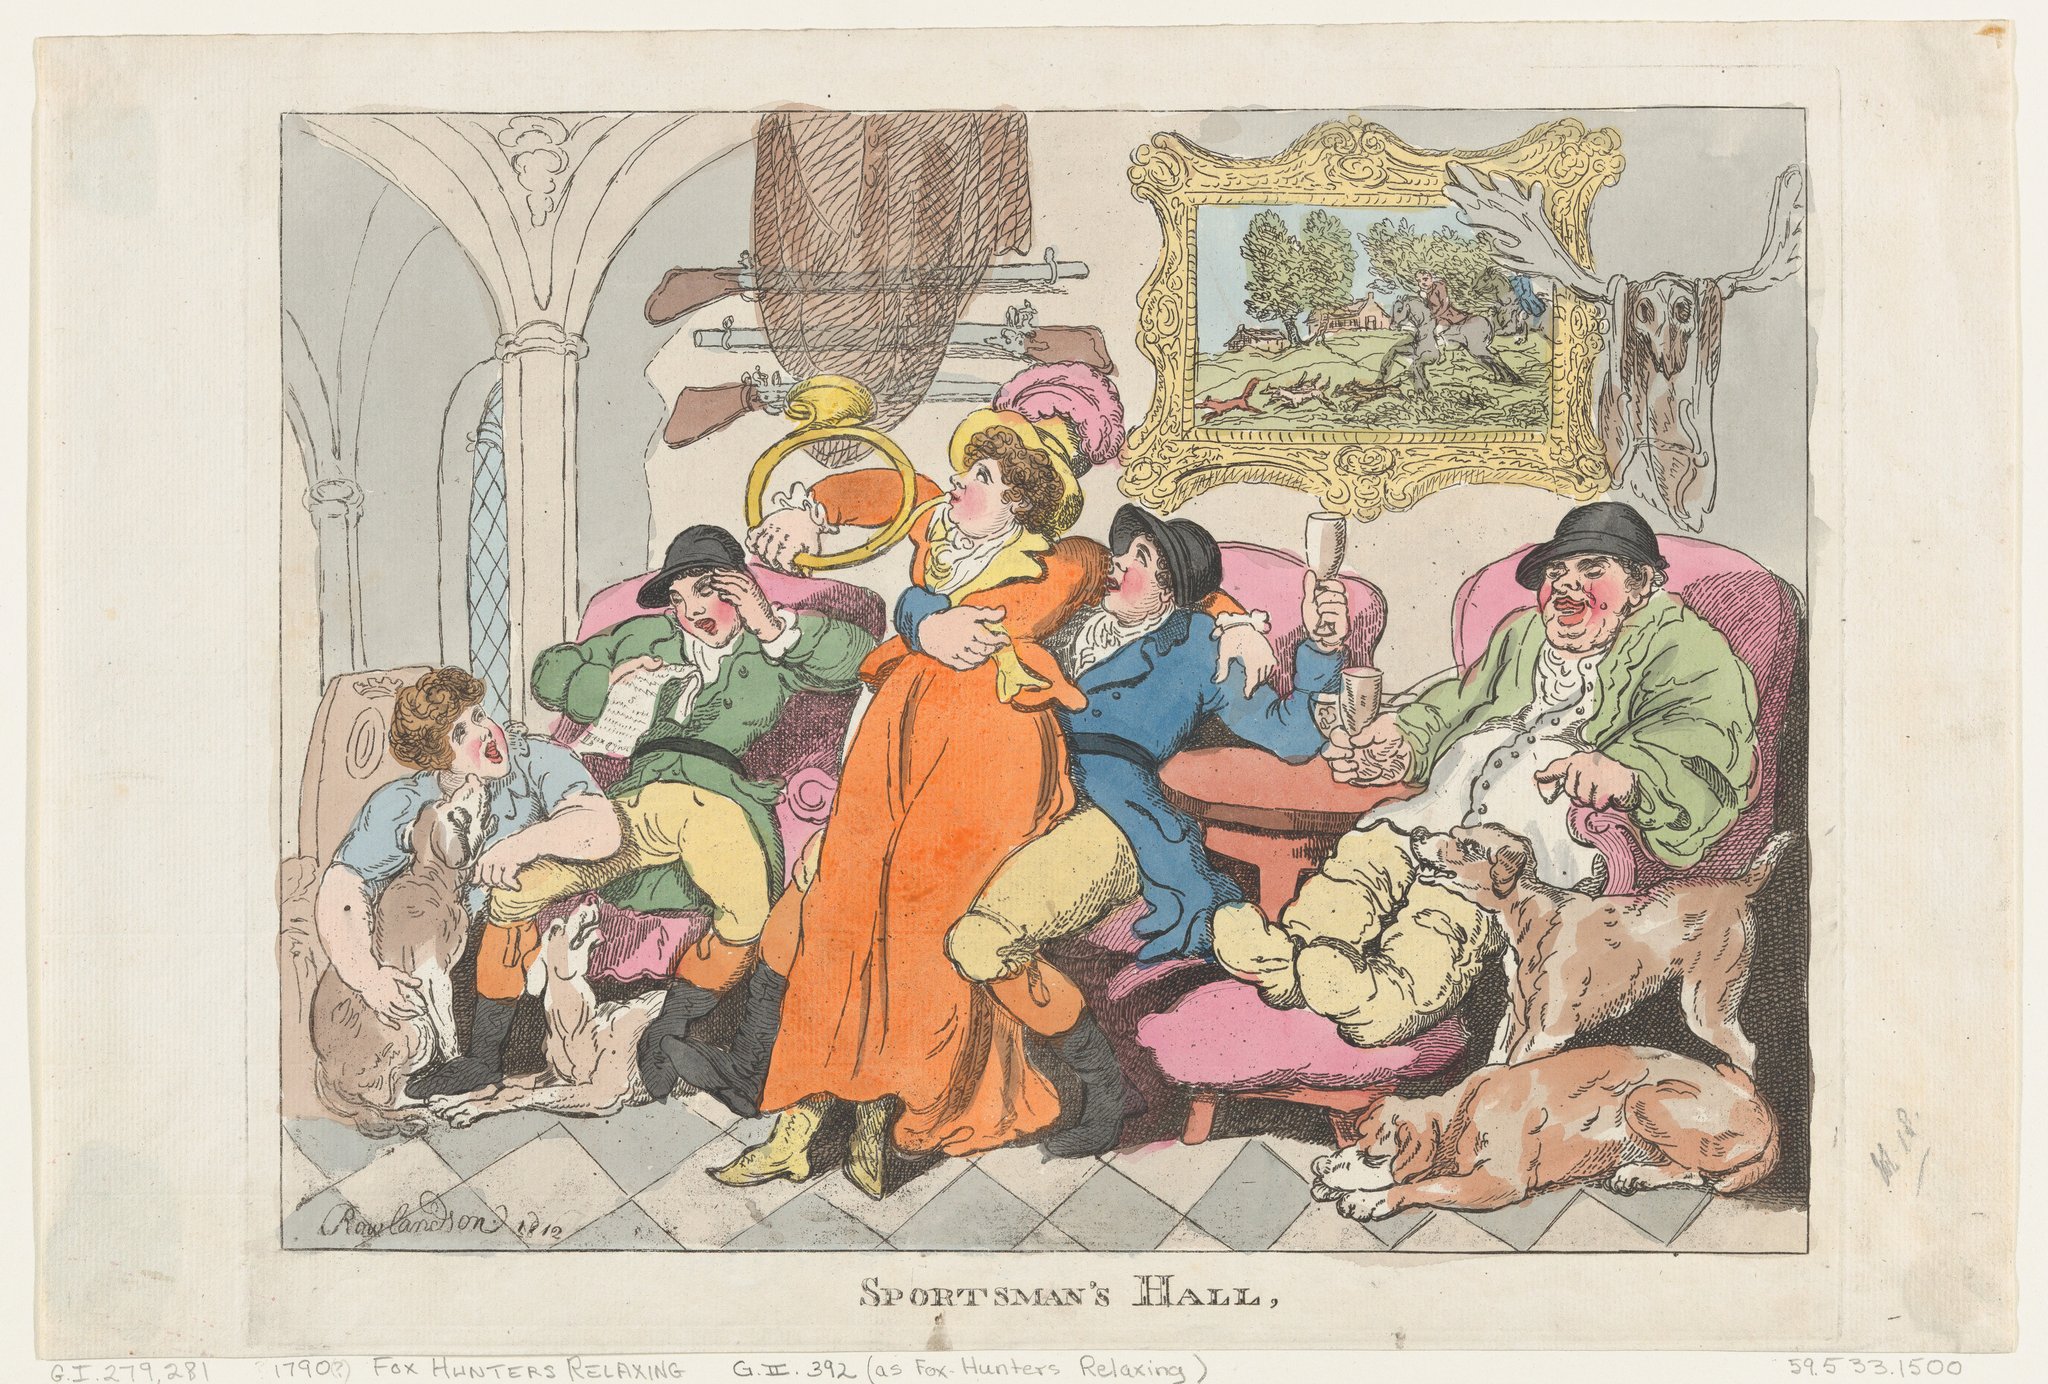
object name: print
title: Sportsman's Hall, or Fox-Hunters Relaxing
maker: thomas rowlandson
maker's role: artist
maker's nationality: british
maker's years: 1757-1827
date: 1812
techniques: etching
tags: men,women,dogs,drinking